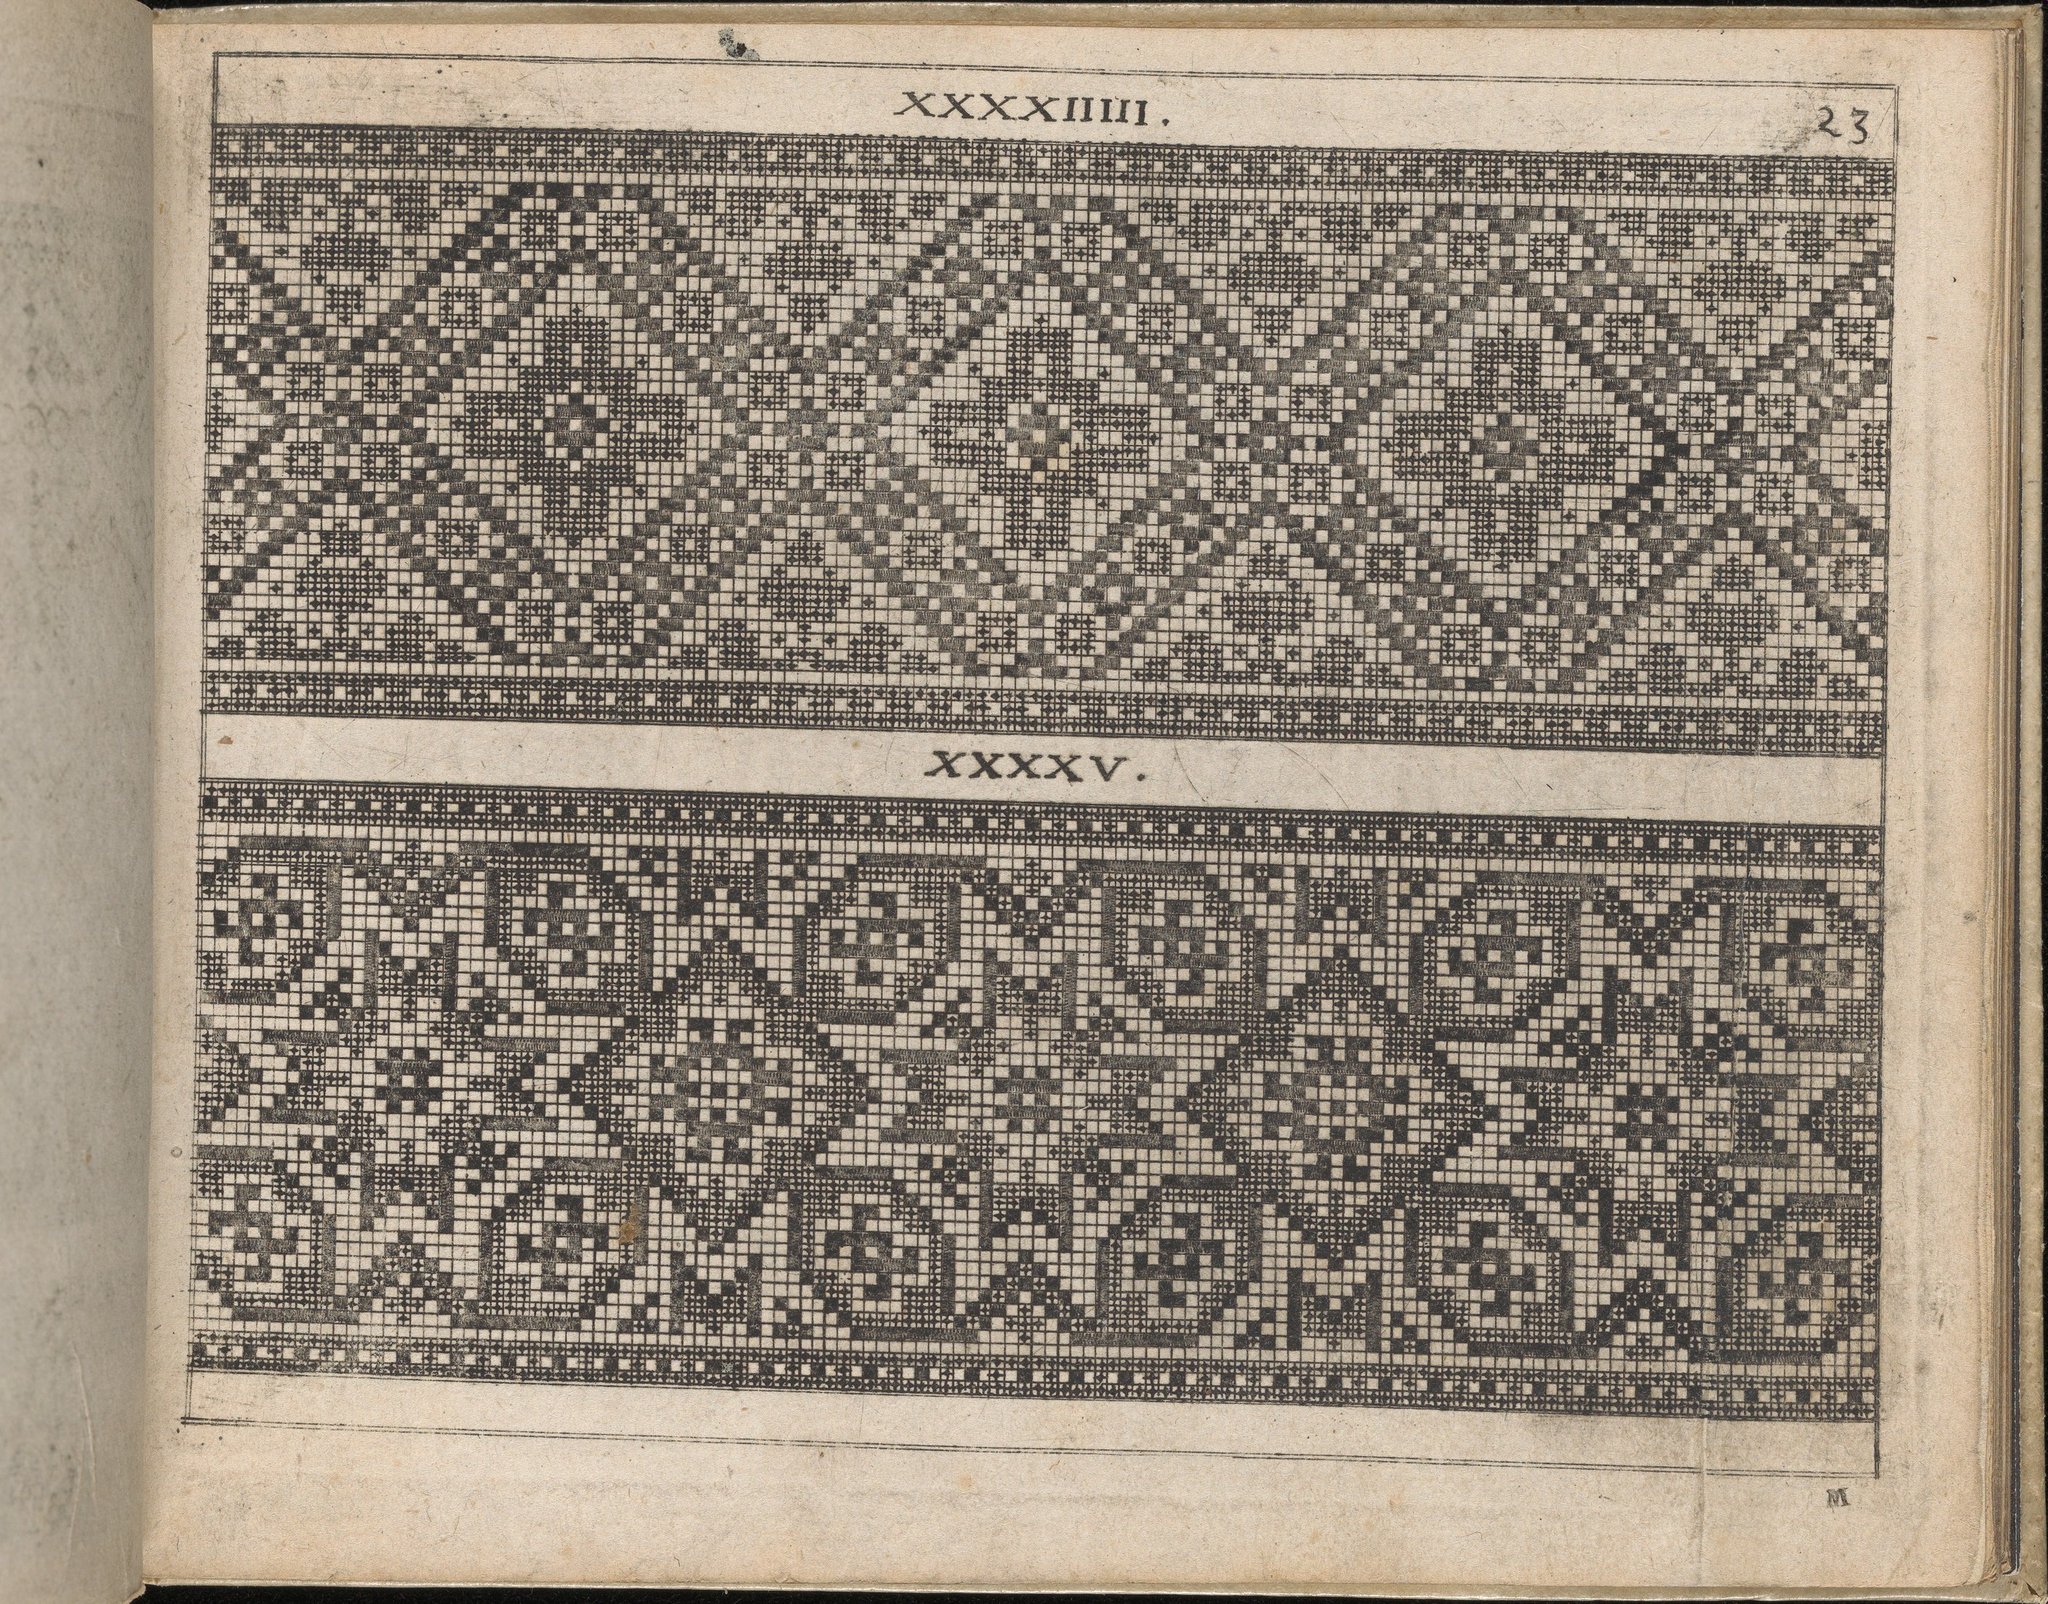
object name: book print ornament architecture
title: Newes Modelbuch in Kupffer (Page 32r)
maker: johann sibmacher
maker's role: artist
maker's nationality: german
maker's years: 1590-1611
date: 1604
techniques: etching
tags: ornament